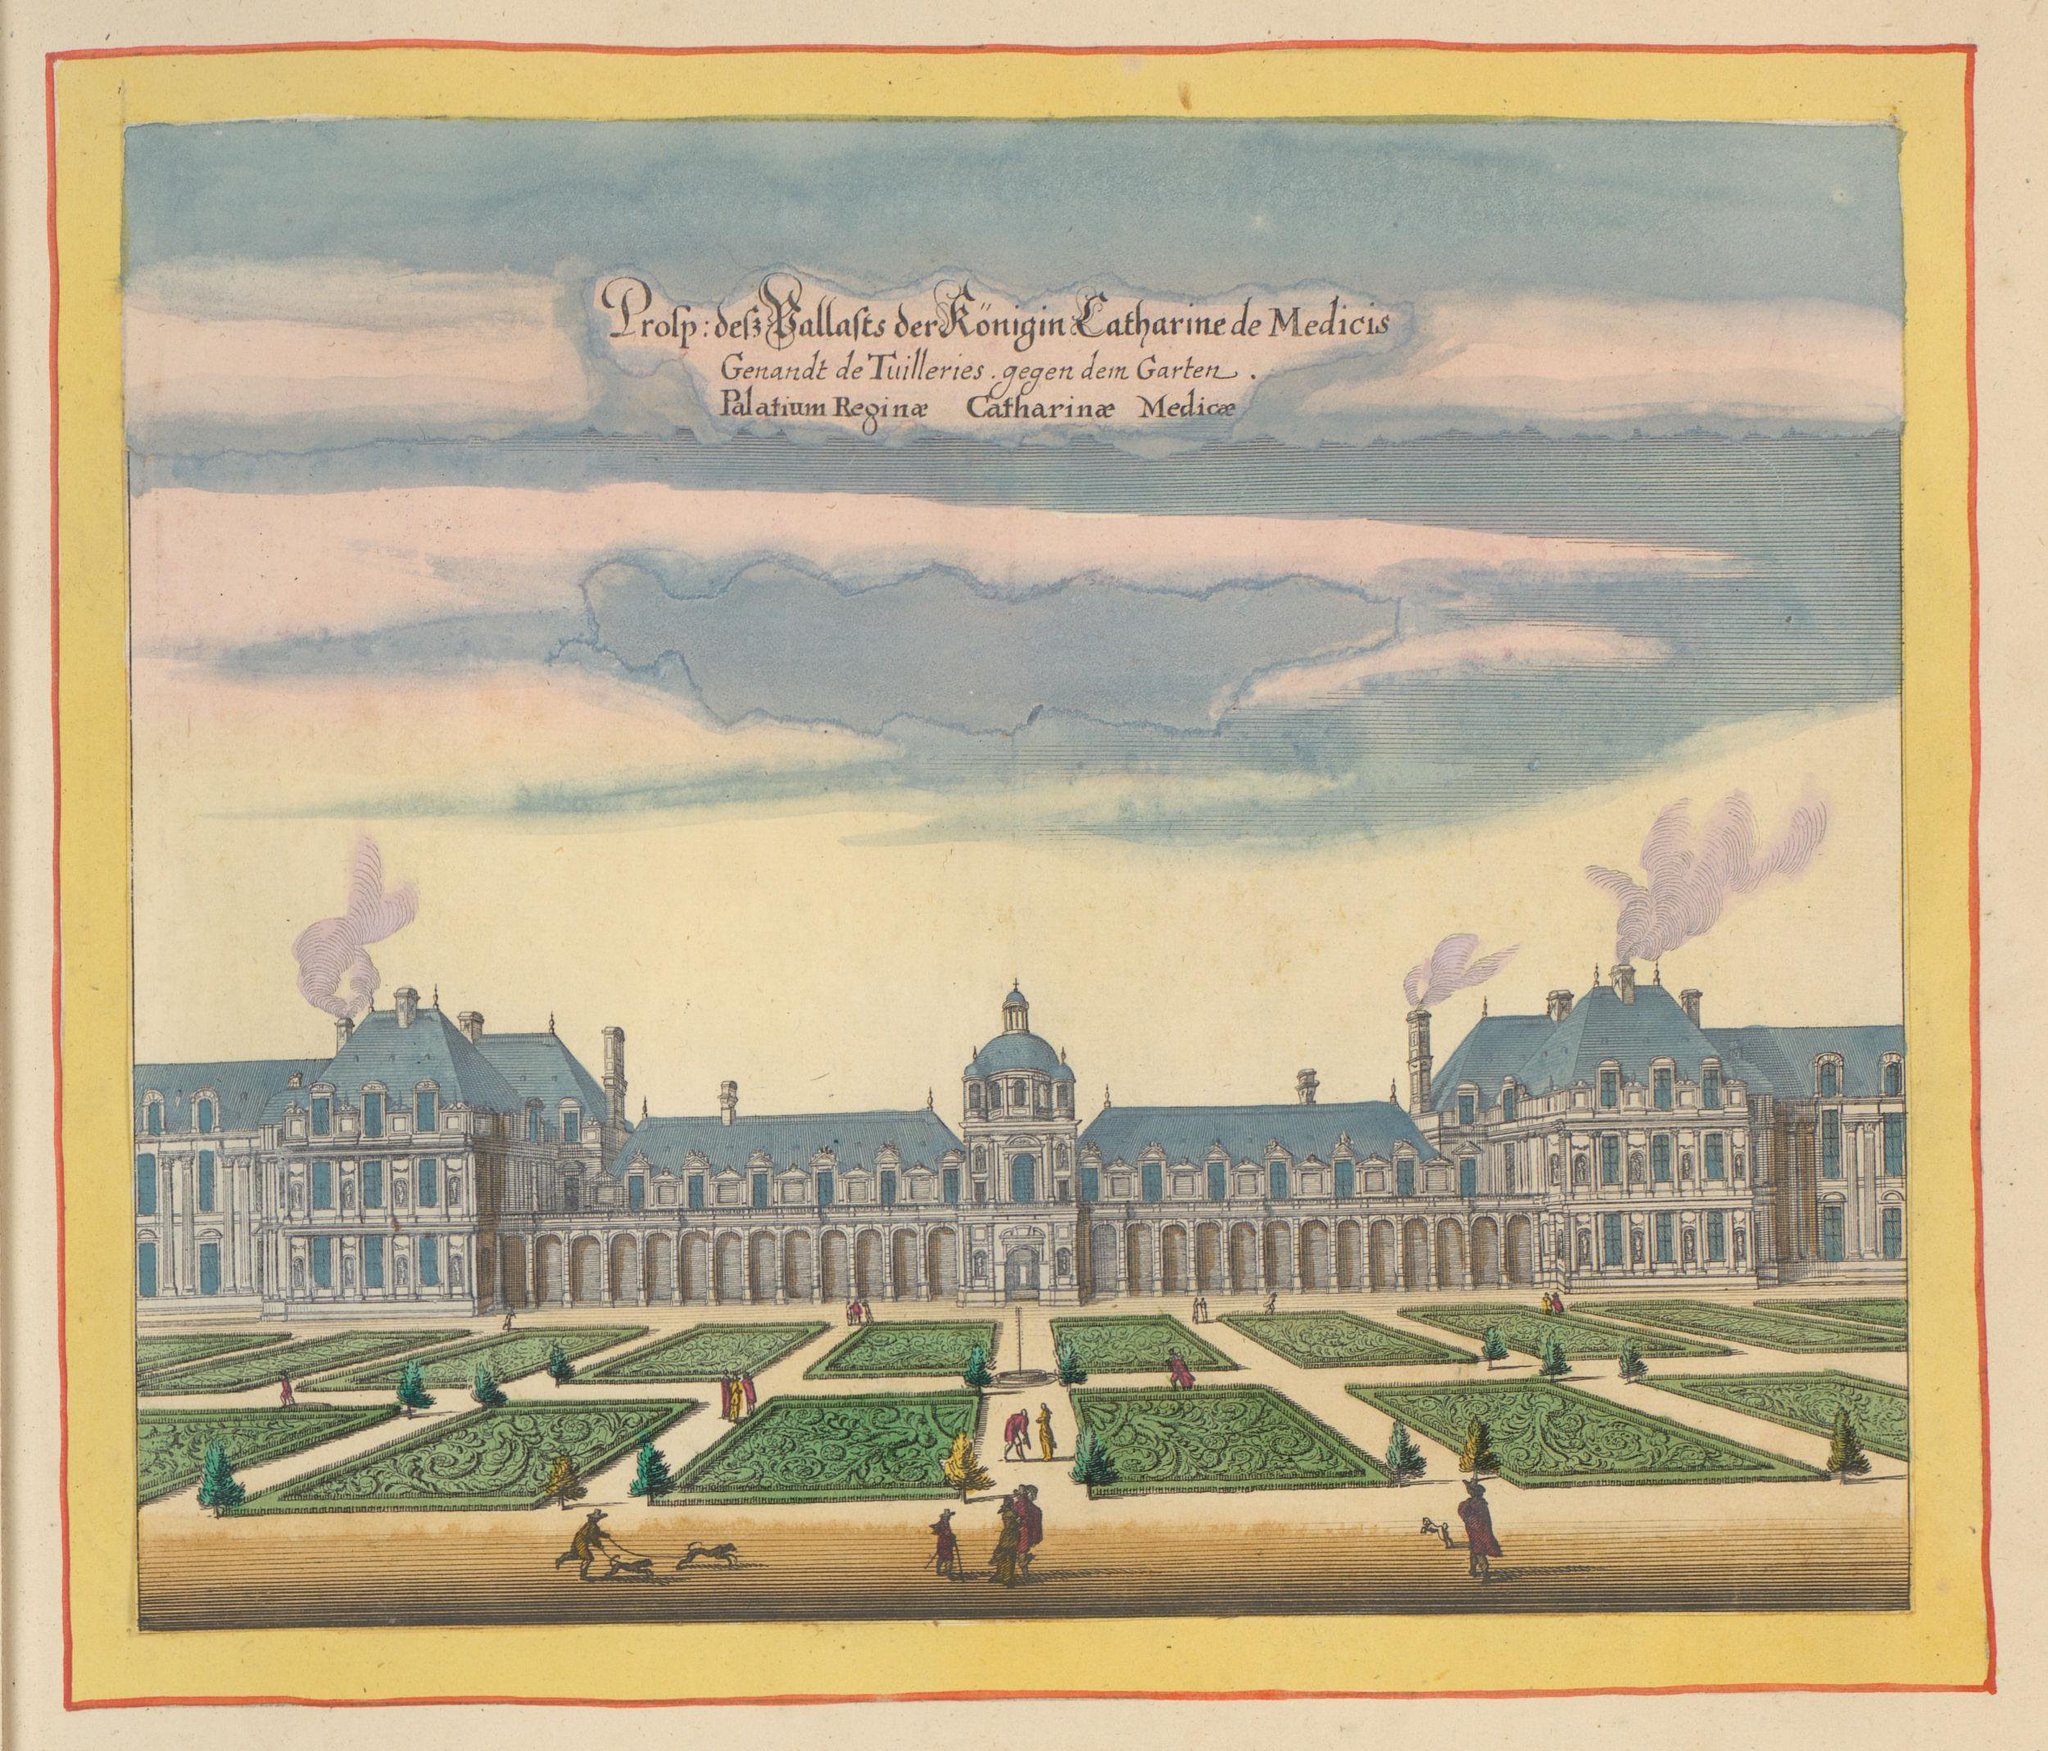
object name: print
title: Gezicht op het Palais des Tuileries vanaf de tuinen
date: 1655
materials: paper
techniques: engraving, etching, hand coloring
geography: the hague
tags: palace, tuileries palace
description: Prent origineel vervaardigd als boekillustratie voor: Zeiller, Martin. Topographia Galliae, oder Beschreibung und Contrafaitung der vornehmbsten und bekantisten Oerter in dem mächtigen und grossen Königreich Frankreich, 13 delen. Frankfurt am Main: Caspar Merian, 1655-1661. De prent werd voor het eerst gepubliceerd in deel 1: Topographia Galliae, 1655.